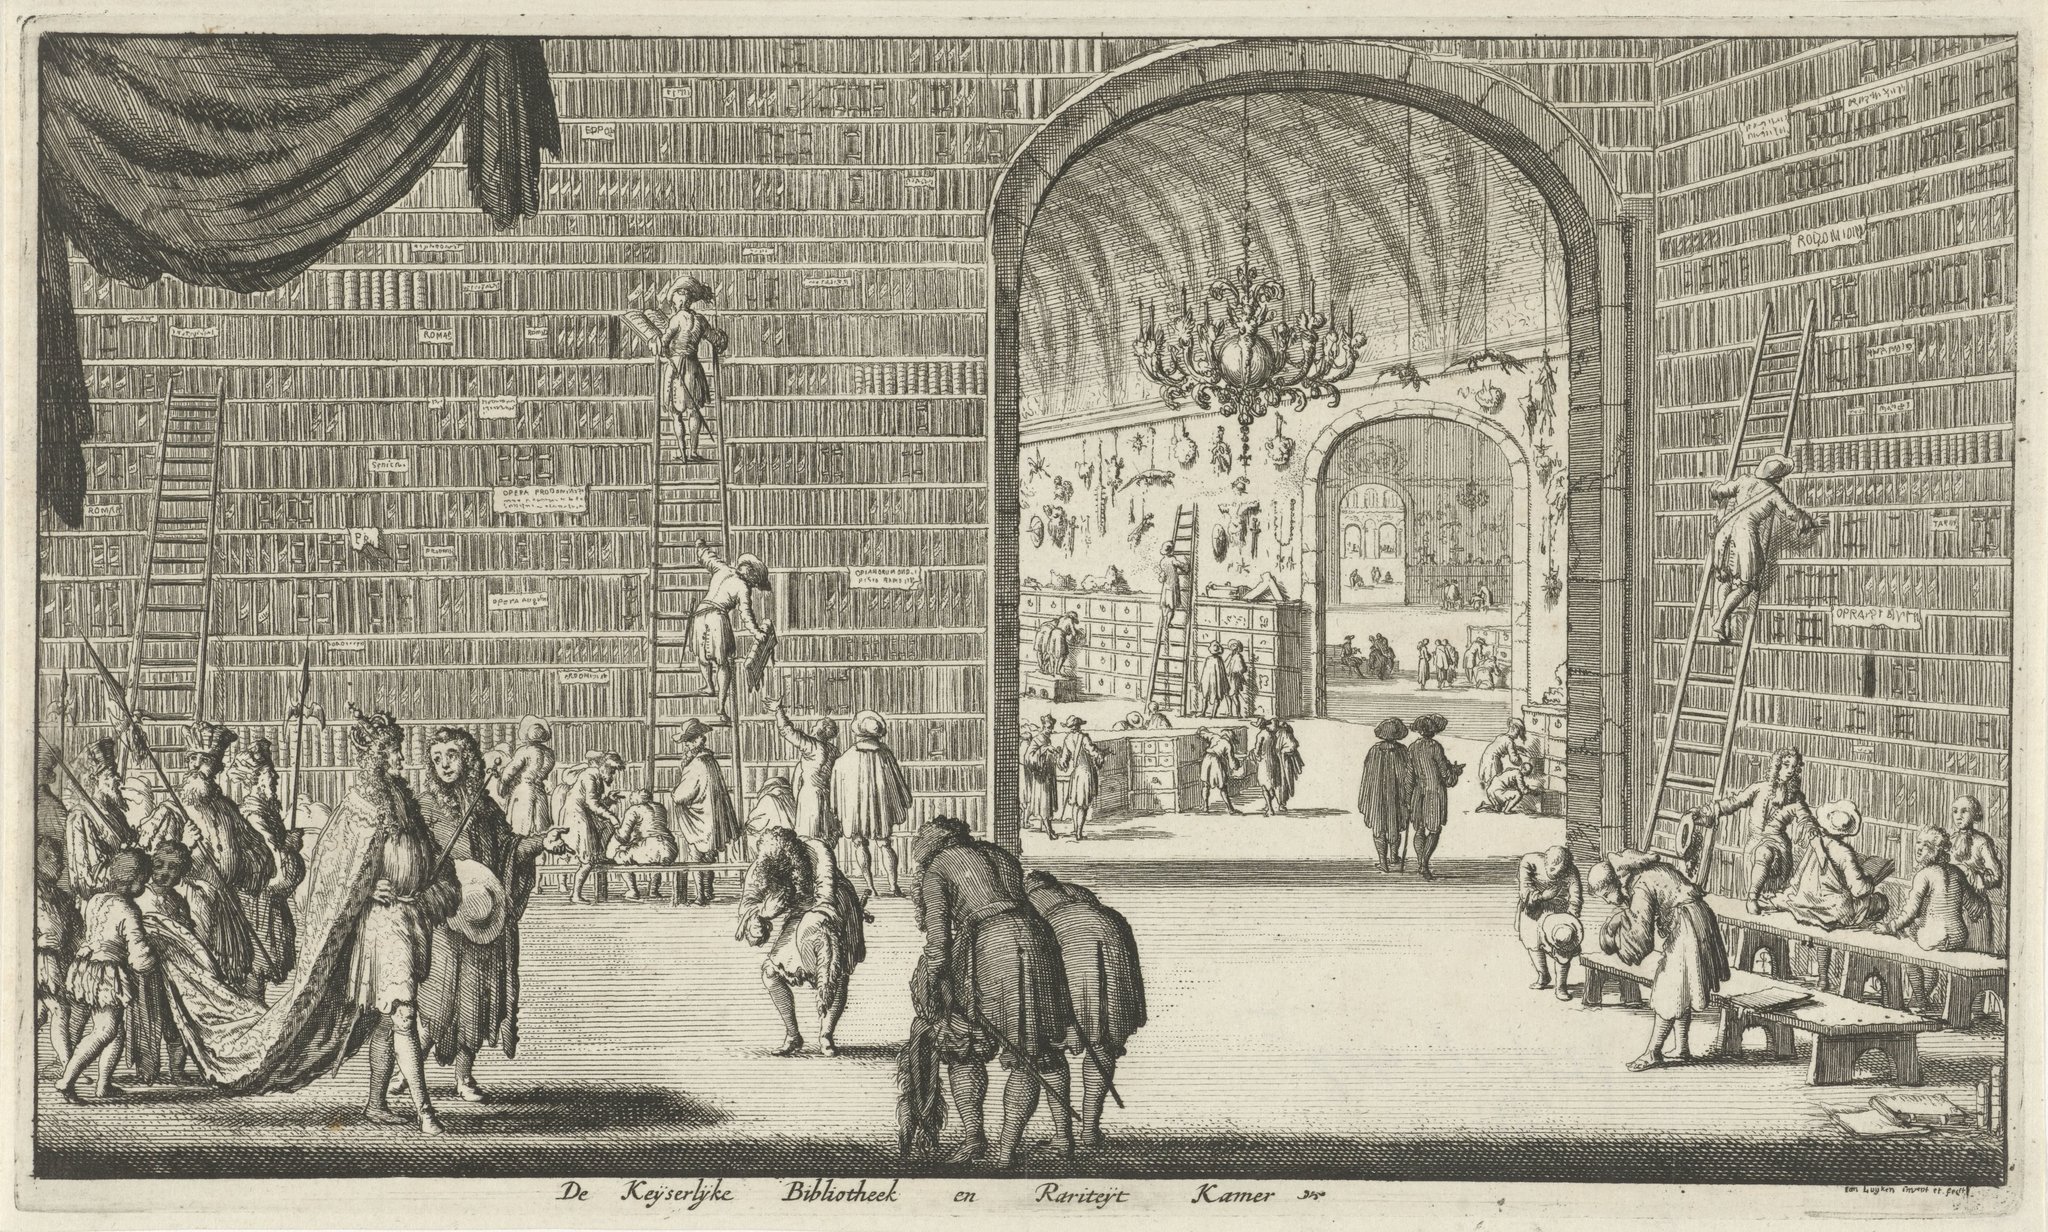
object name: print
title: De Keijserlijke Bibliotheek en Rariteijt Kamer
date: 1682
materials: paper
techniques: etching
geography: amsterdam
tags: study; 'studiolo'; library, cabinet of curiosities, 'kunst- und wunderkammer'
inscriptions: collector's mark: Lugt 2228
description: Illustratie opgenomen in: Brown, Edward. Naauwkeurige en gedenkwaardige reysen van Edward Brown (...) door Nederland, Duytsland, Hongaryen, Boek III, p. 24. Amsterdam: Jan Claesz ten Hoorn, 1682.